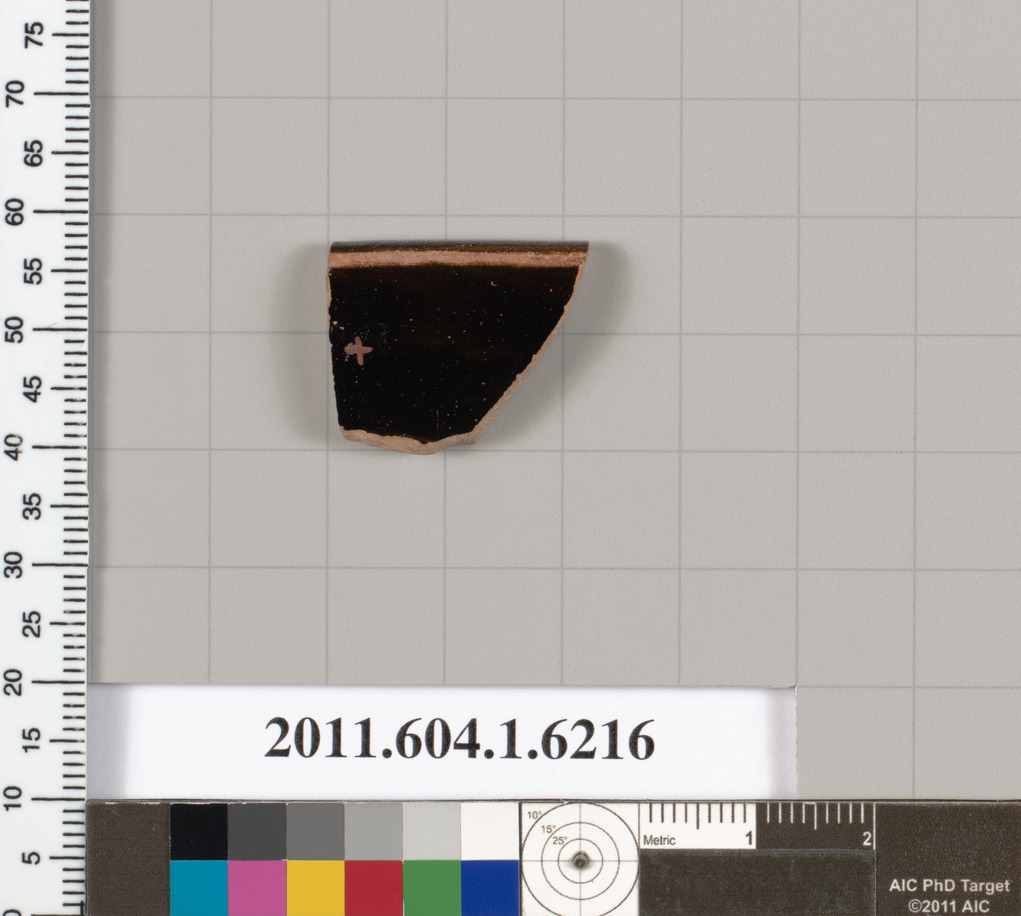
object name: kylix fragment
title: Terracotta rim fragment of a kylix (drinking cup)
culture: greek, attic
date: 510-500 BCE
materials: terracotta